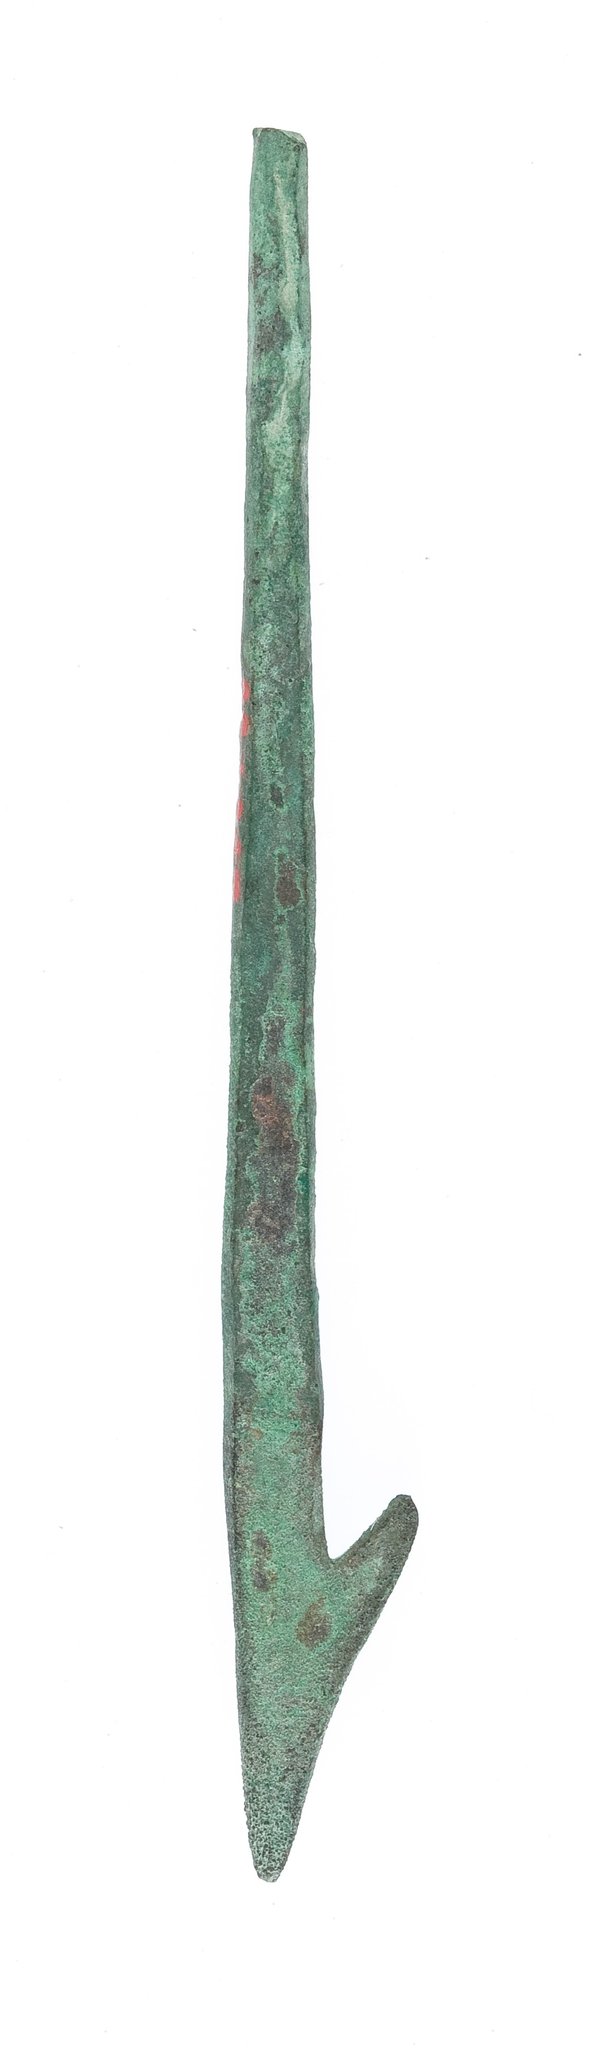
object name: harpoon point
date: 1295-1070 BCE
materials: bronze, copper alloy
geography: egypt